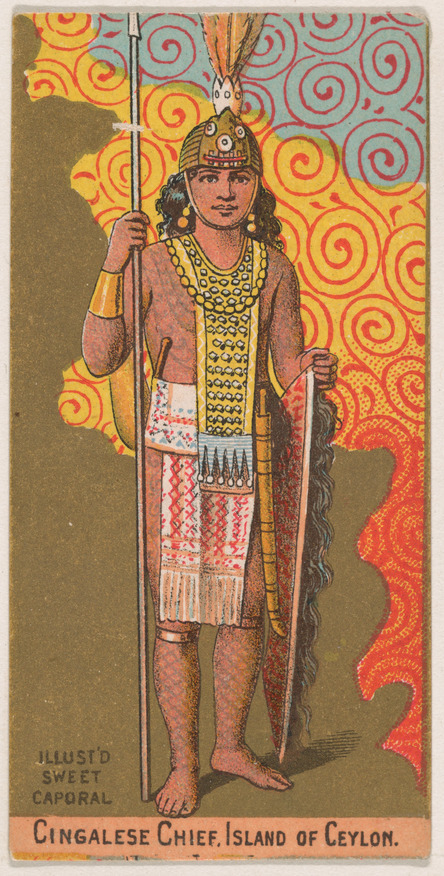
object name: print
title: Cingalese Chief, Island of Ceylon, from the Military Series (N224) issued by Kinney Tobacco Company to promote Sweet Caporal Cigarettes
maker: kinney brothers tobacco company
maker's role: publisher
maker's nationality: american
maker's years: 1869-2011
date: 1888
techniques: color lithograph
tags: military,shields,swords,men